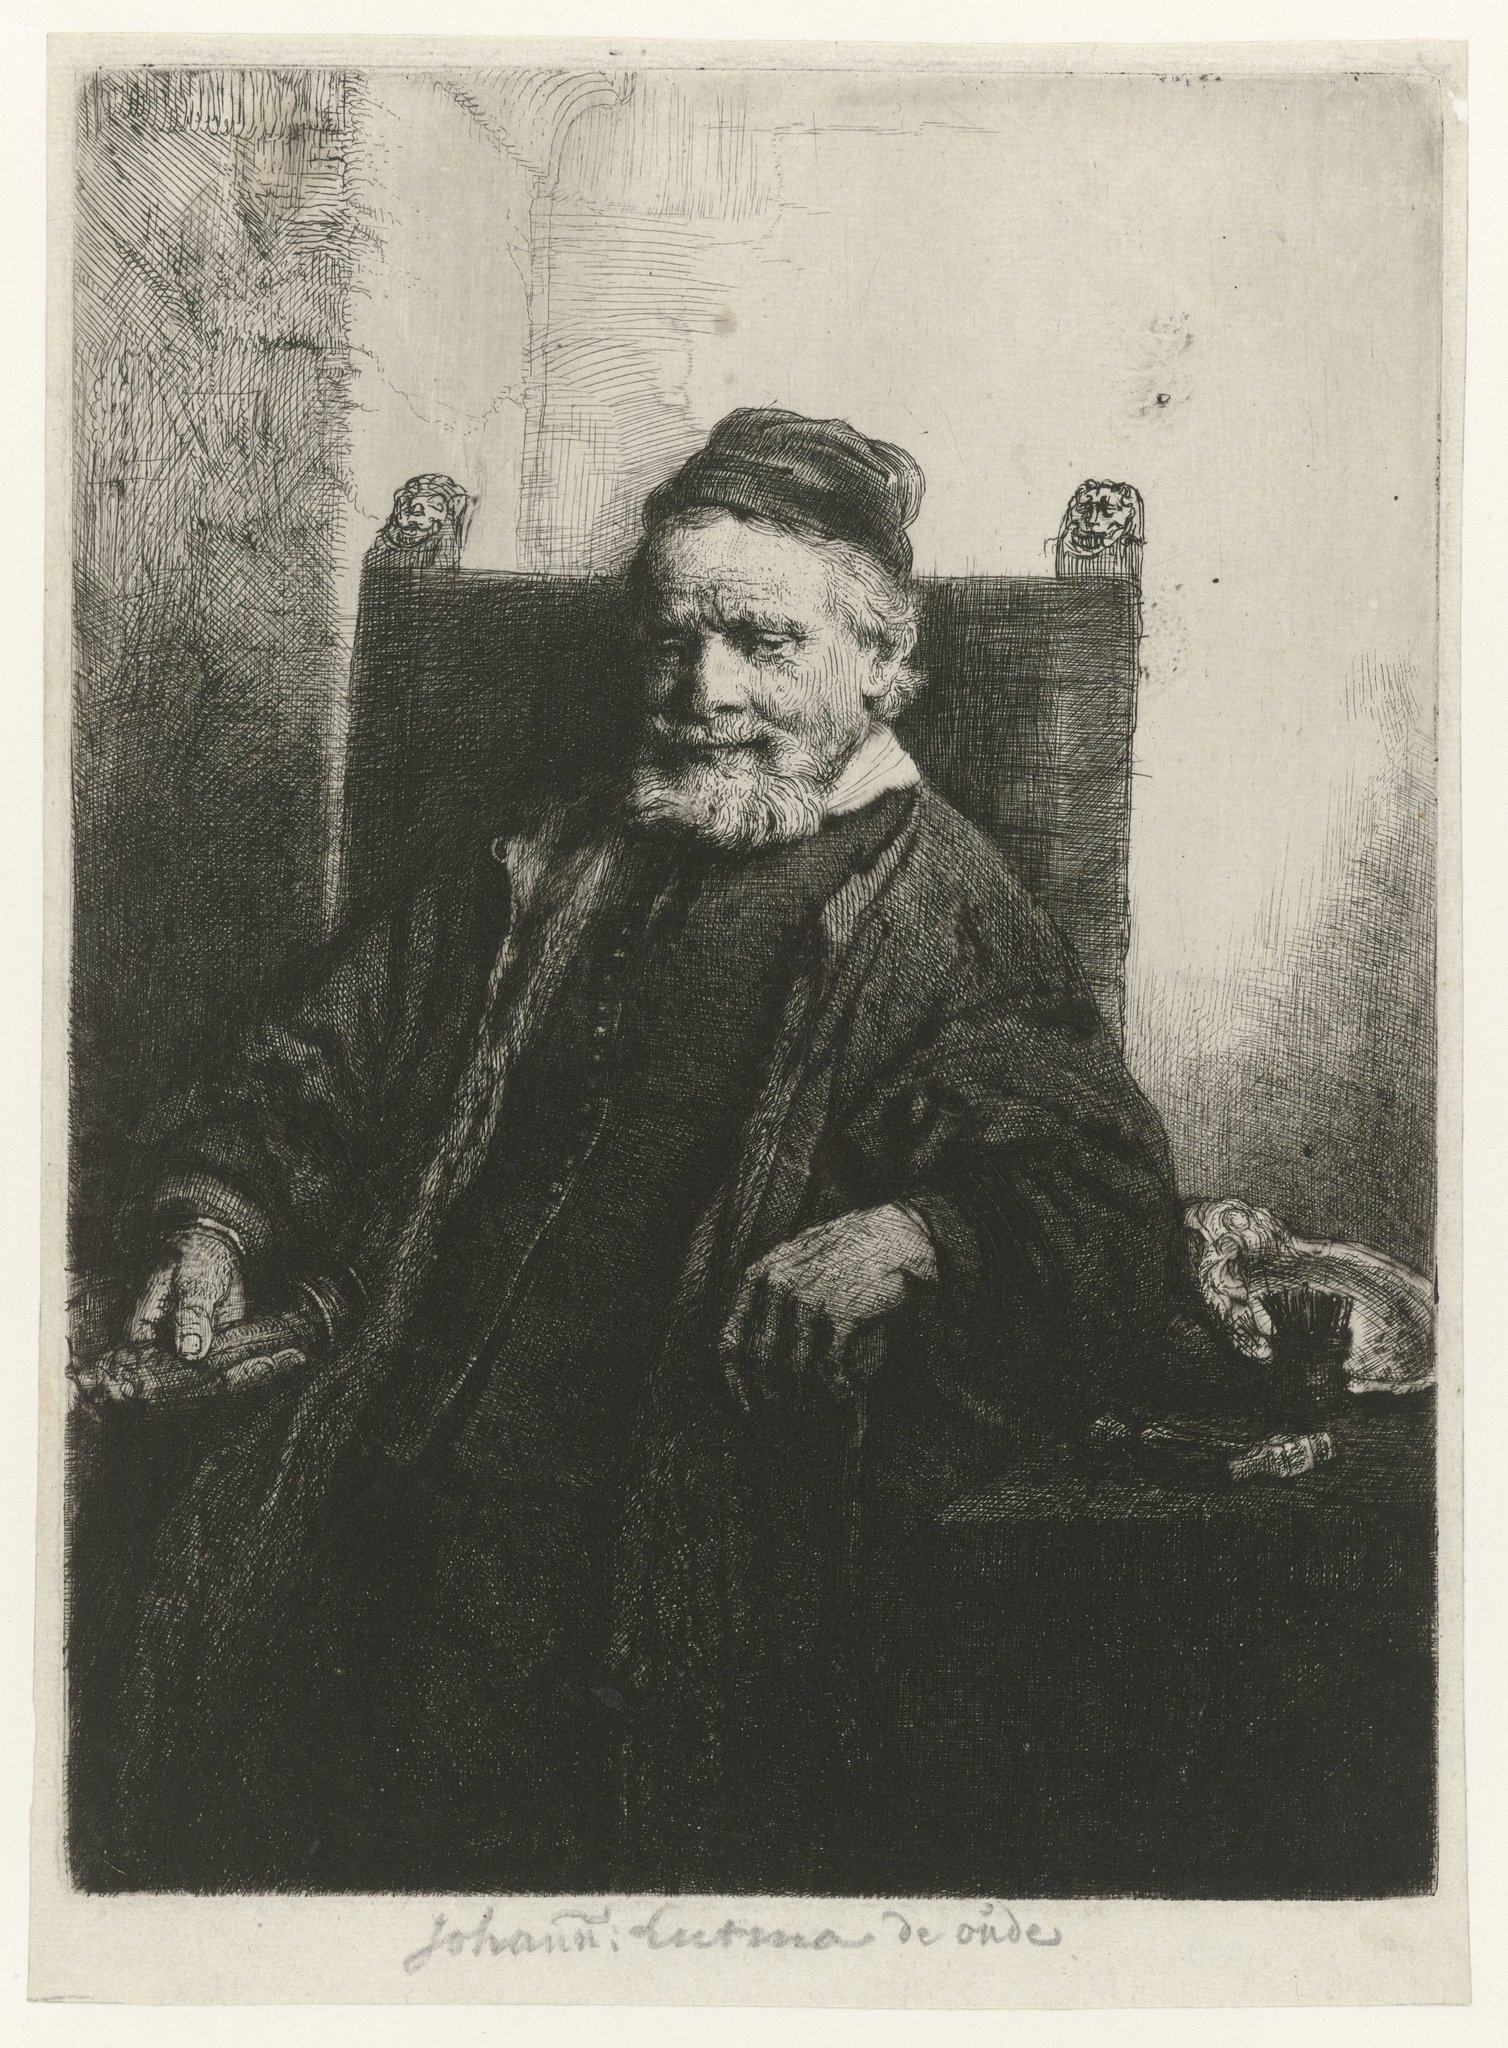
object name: print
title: Jan Lutma, goldsmith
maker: rembrandt van rijn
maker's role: draughtsman, painter, print maker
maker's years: 1606-1669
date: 1656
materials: paper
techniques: drypoint, etching, intaglio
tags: silversmith, johannes lutma (1584-1669)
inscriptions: collector's mark: Lugt 240, inscription: ‘Johann: Lutm de oude’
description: In the 17th century, the silversmith Johannes Lutma was as famous as a superstar today. Rembrandt portrays him as a ruler in a stately armchair. Next to Lutma is one of his works, a silver drinking bowl. Next to it are tools of his trade, a small sledgehammer and a jar with pounces. In the reversed counterproof, Rembrandt used grey-brown ink to try out a different background.